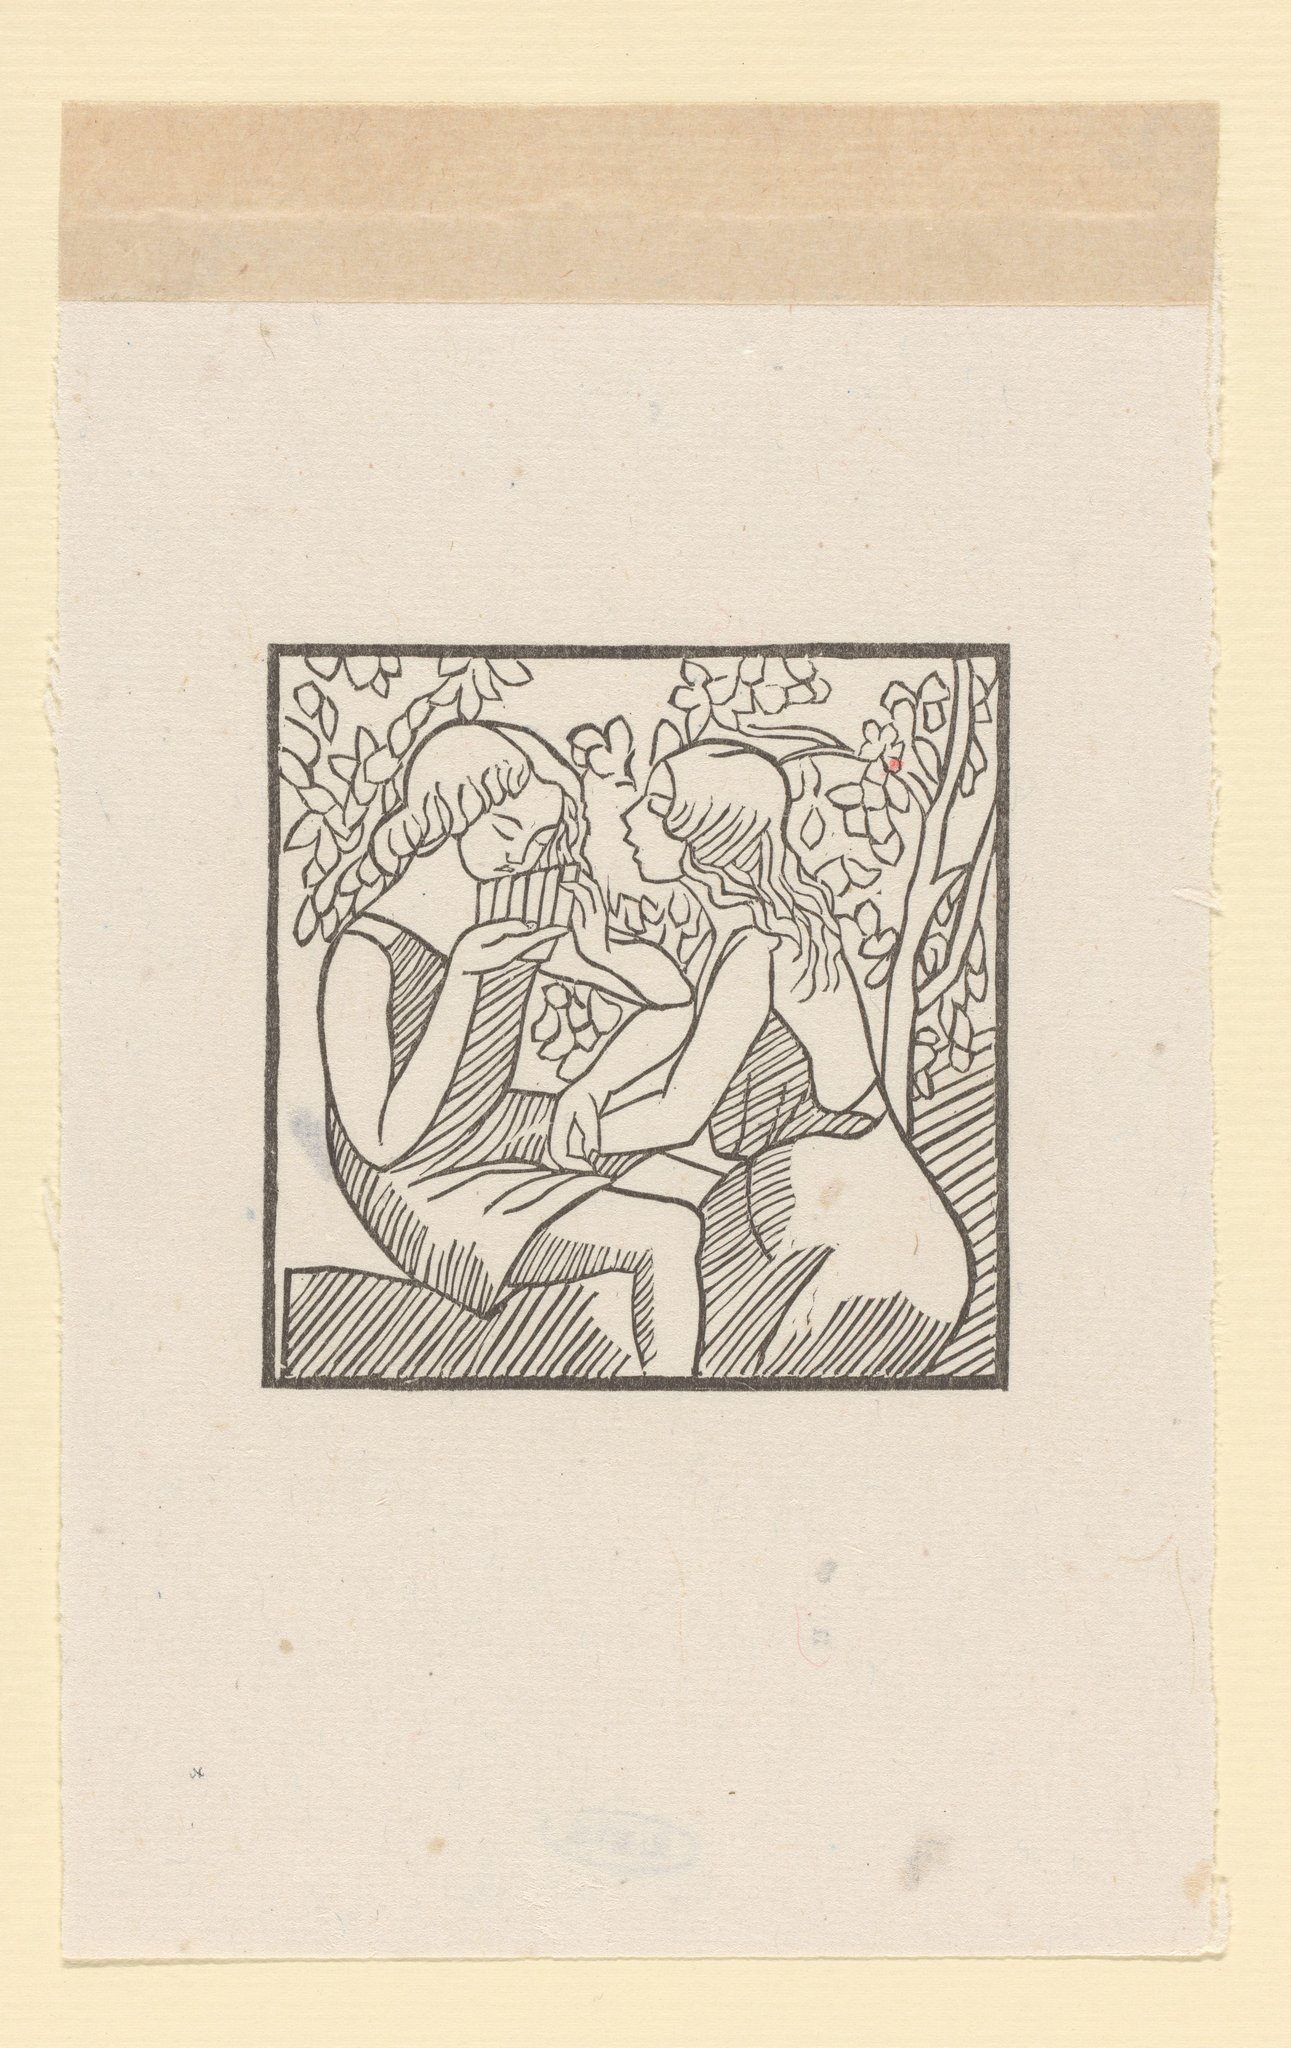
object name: print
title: Daphnis speelt panfluit voor Chloé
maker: aristide maillol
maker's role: draughtsman, painter, print maker, sculptor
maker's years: 1861-1944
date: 1937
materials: paper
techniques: woodcut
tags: panpipes, daphnis (in greek mythology a shepherd who invented pastoral poetry, chloe, one person playing an instrument - cc - out of doors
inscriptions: collector's mark: Lugt 2228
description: Latere staat van deze prent gebruikt in: Longus. Les Pastorales de Longus ou Daphnis & Chloé. Parijs: Frères Gonin, 1935, p. 23. Het gaat hier duidelijk om een proefdruk; tekst en paginering kloppen niet met de uiteindelijke publicatie.